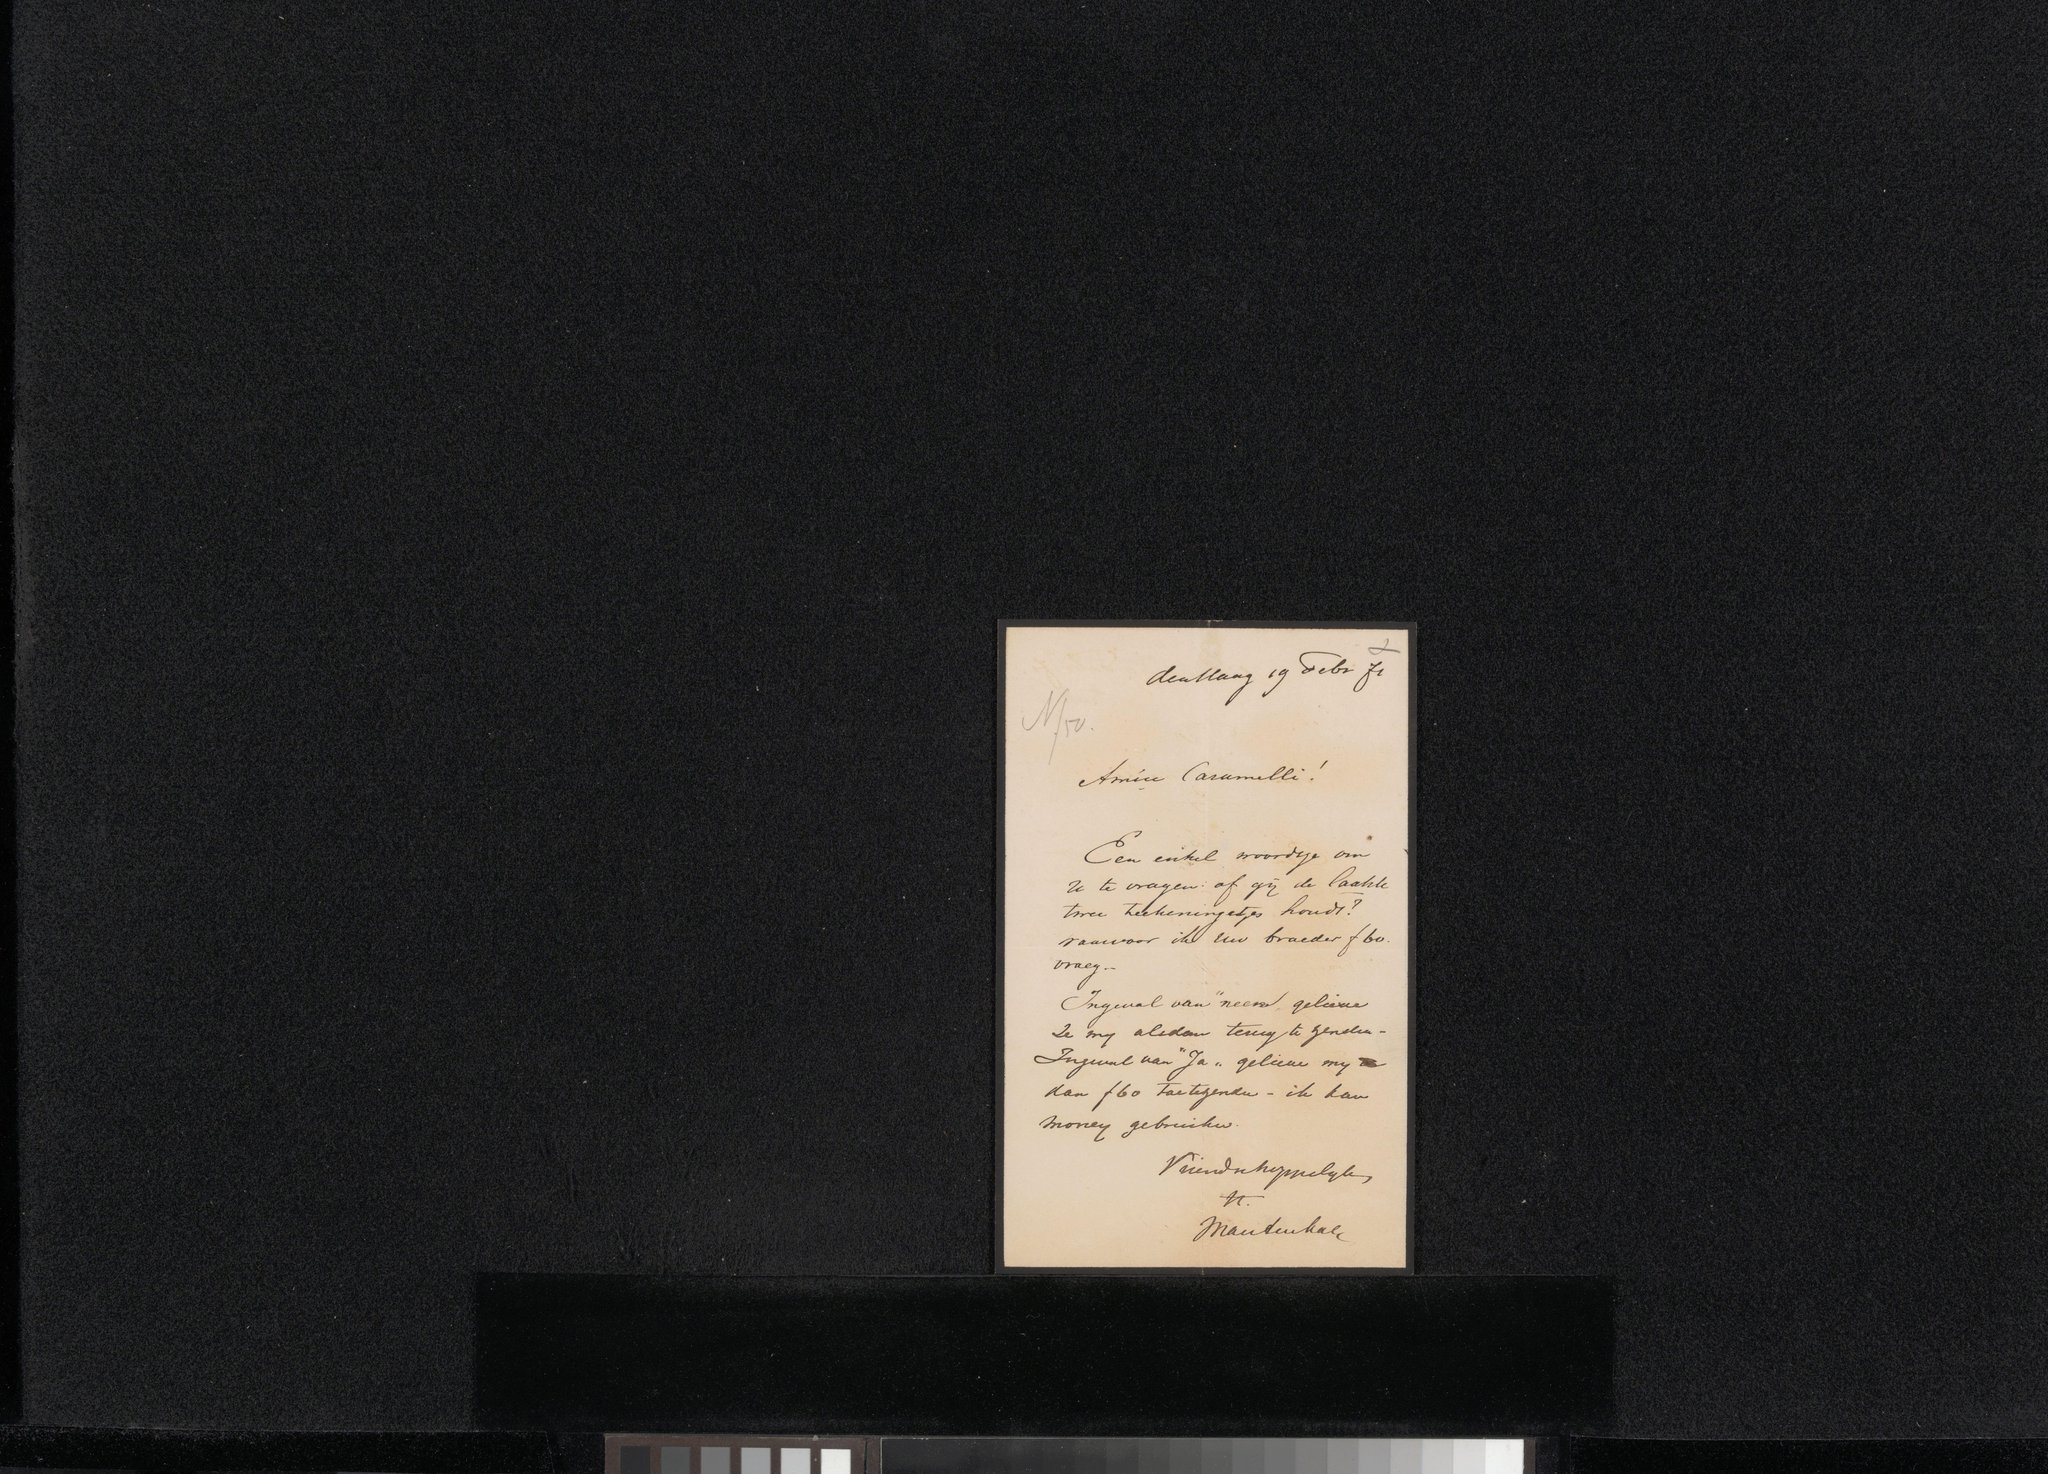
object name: letter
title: Brief aan de heer Caramelli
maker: mari ten kate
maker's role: draughtsman, painter, print maker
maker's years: 1831-1910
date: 1871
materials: ink, paper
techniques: pen, writing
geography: the hague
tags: art trade, art shop, drawing, money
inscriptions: collector's mark: Lugt 2233